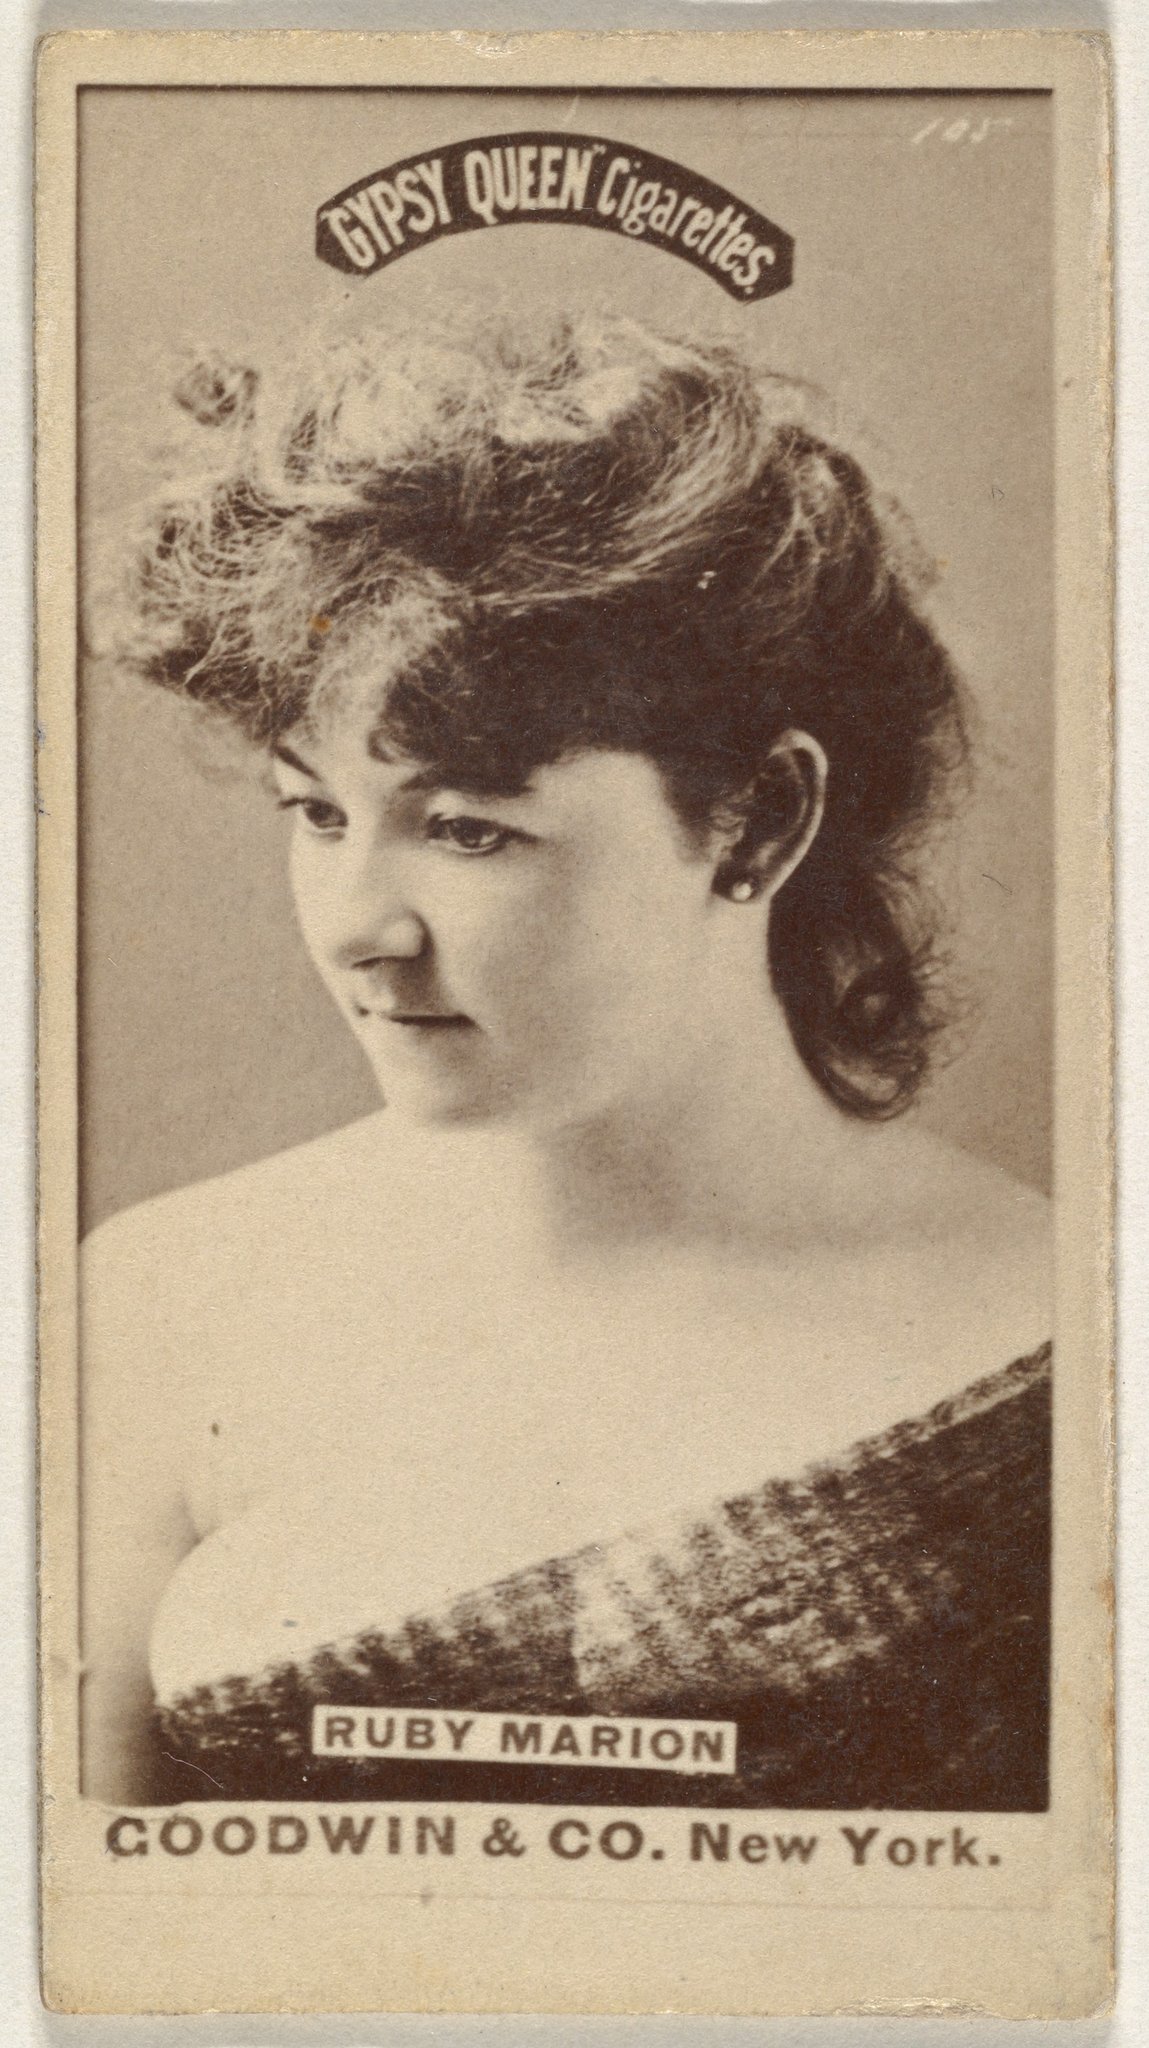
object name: photograph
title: Ruby Marion, from the Actors and Actresses series (N171) for Gypsy Queen Cigarettes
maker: goodwin & company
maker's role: publisher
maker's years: 1850-1950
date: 1886-1890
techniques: albumen silver print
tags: portraits,women,actresses